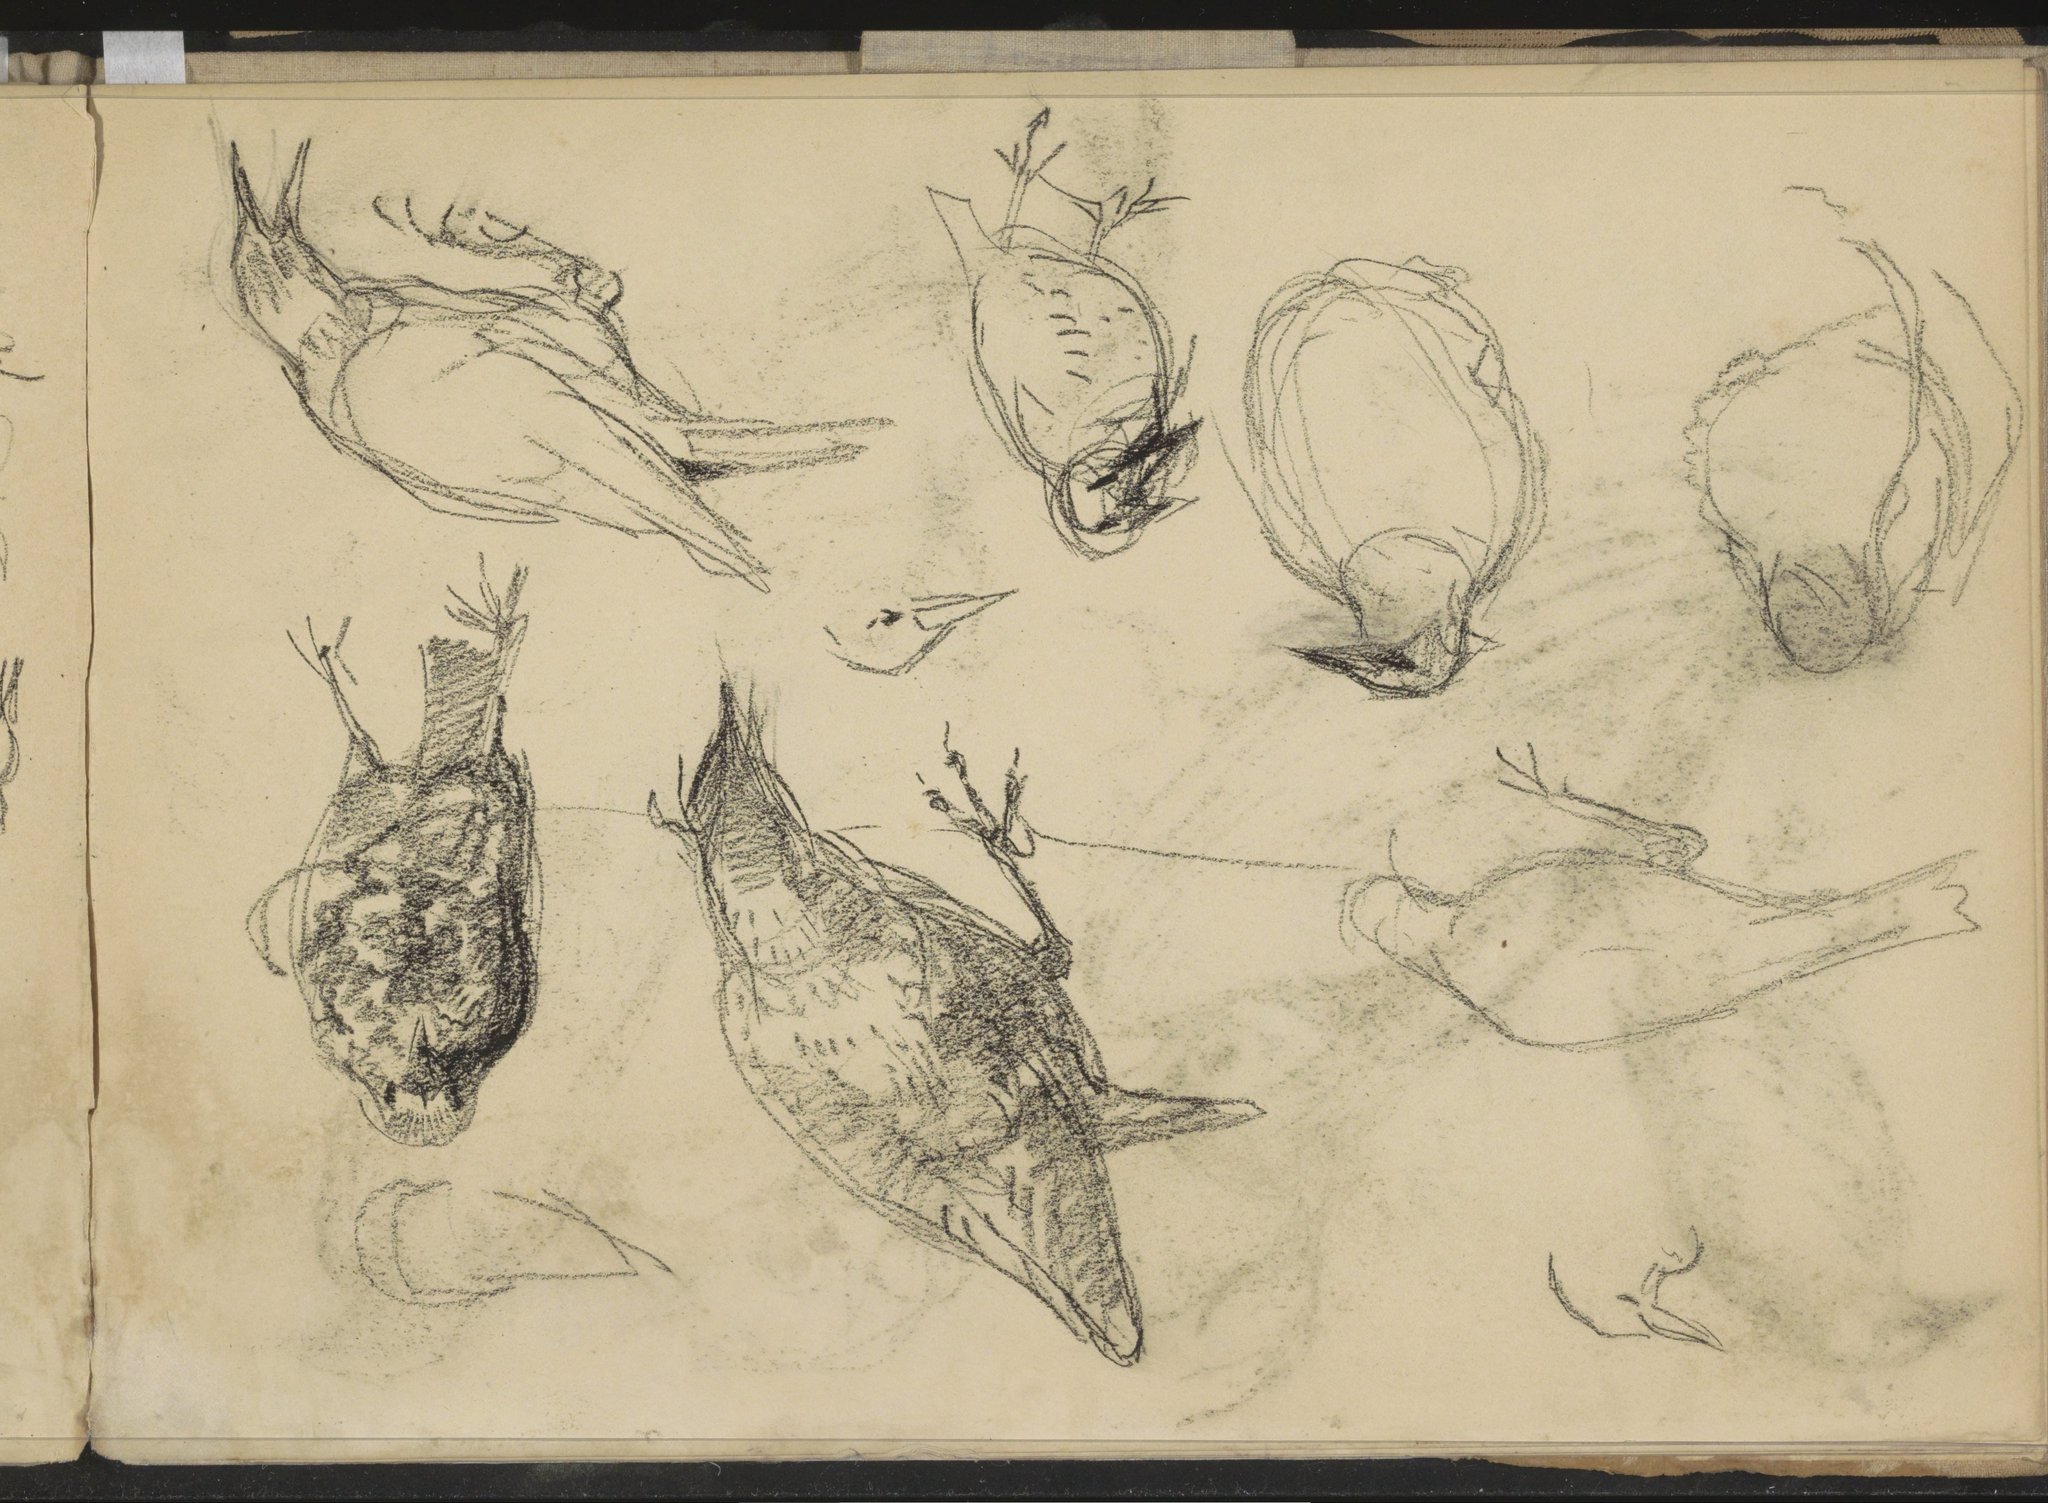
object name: sketchbook leaf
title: Vogels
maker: willem bastiaan tholen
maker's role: draughtsman, painter, print maker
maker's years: 1860-1931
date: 1885-1931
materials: chalk, paper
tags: birds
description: Blad 21 recto uit een schetsboek met 28 bladen.